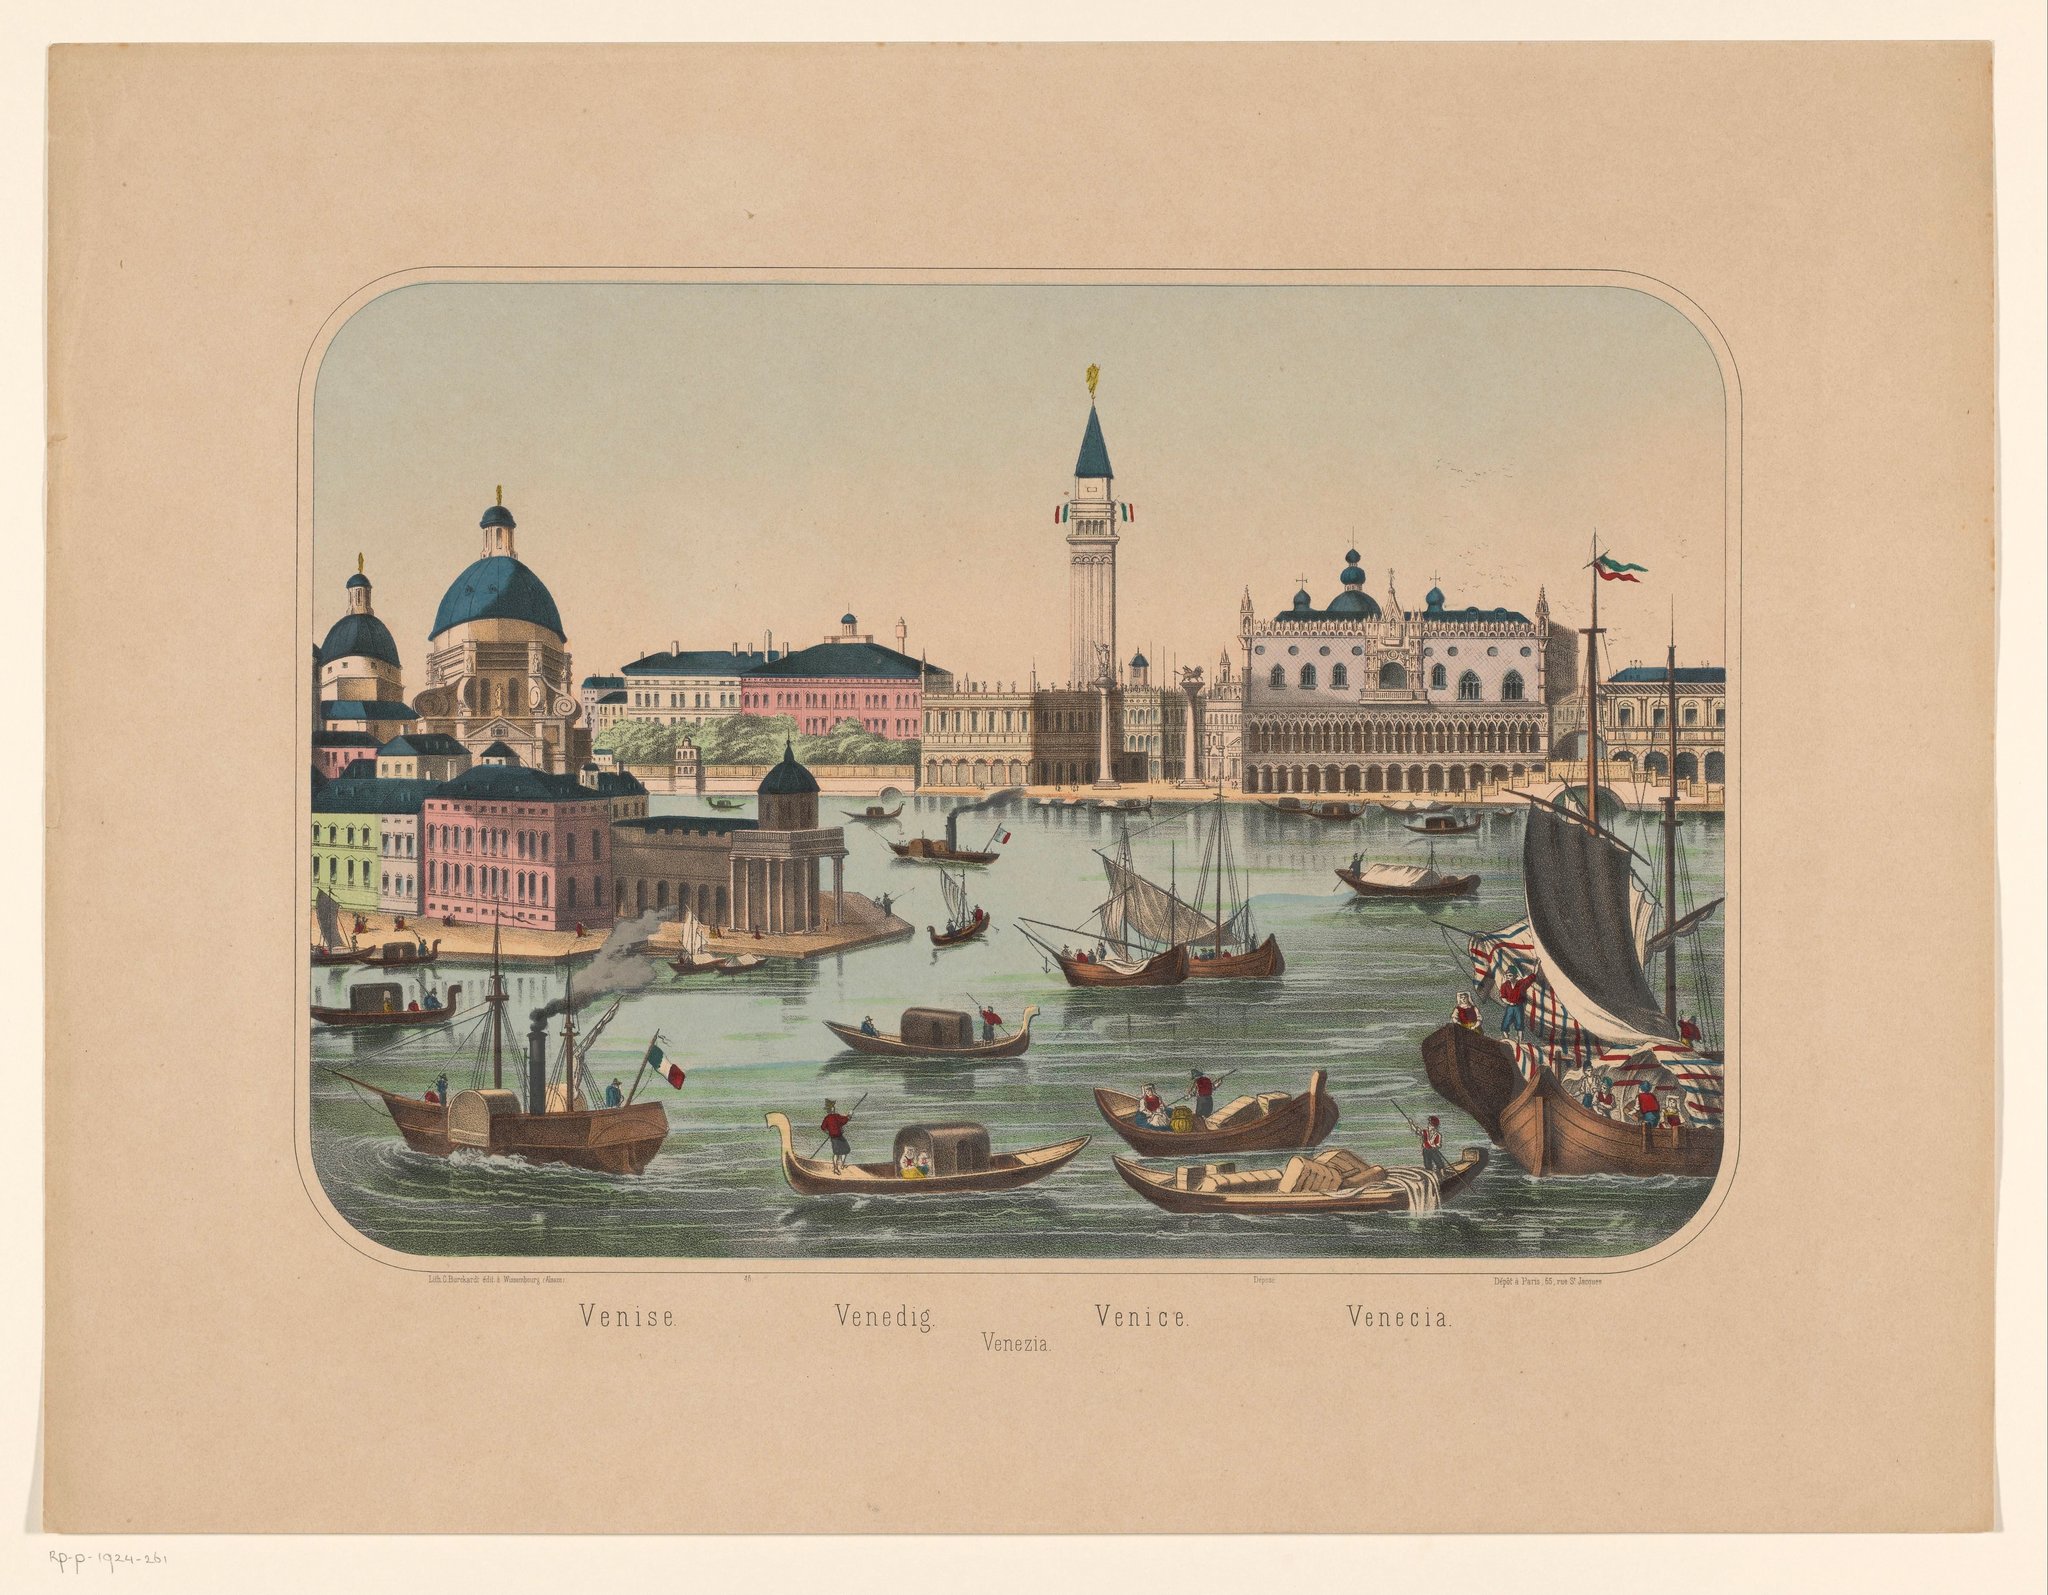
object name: print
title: Venise / Venedig / Venezia / Venice / Venecia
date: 1870-1889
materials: paper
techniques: lithograph, hand coloring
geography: wissembourg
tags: gondola, prospect of city, town panorama, silhouette of city, venice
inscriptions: collector's mark: Lugt 2233, : ‘Déposé’